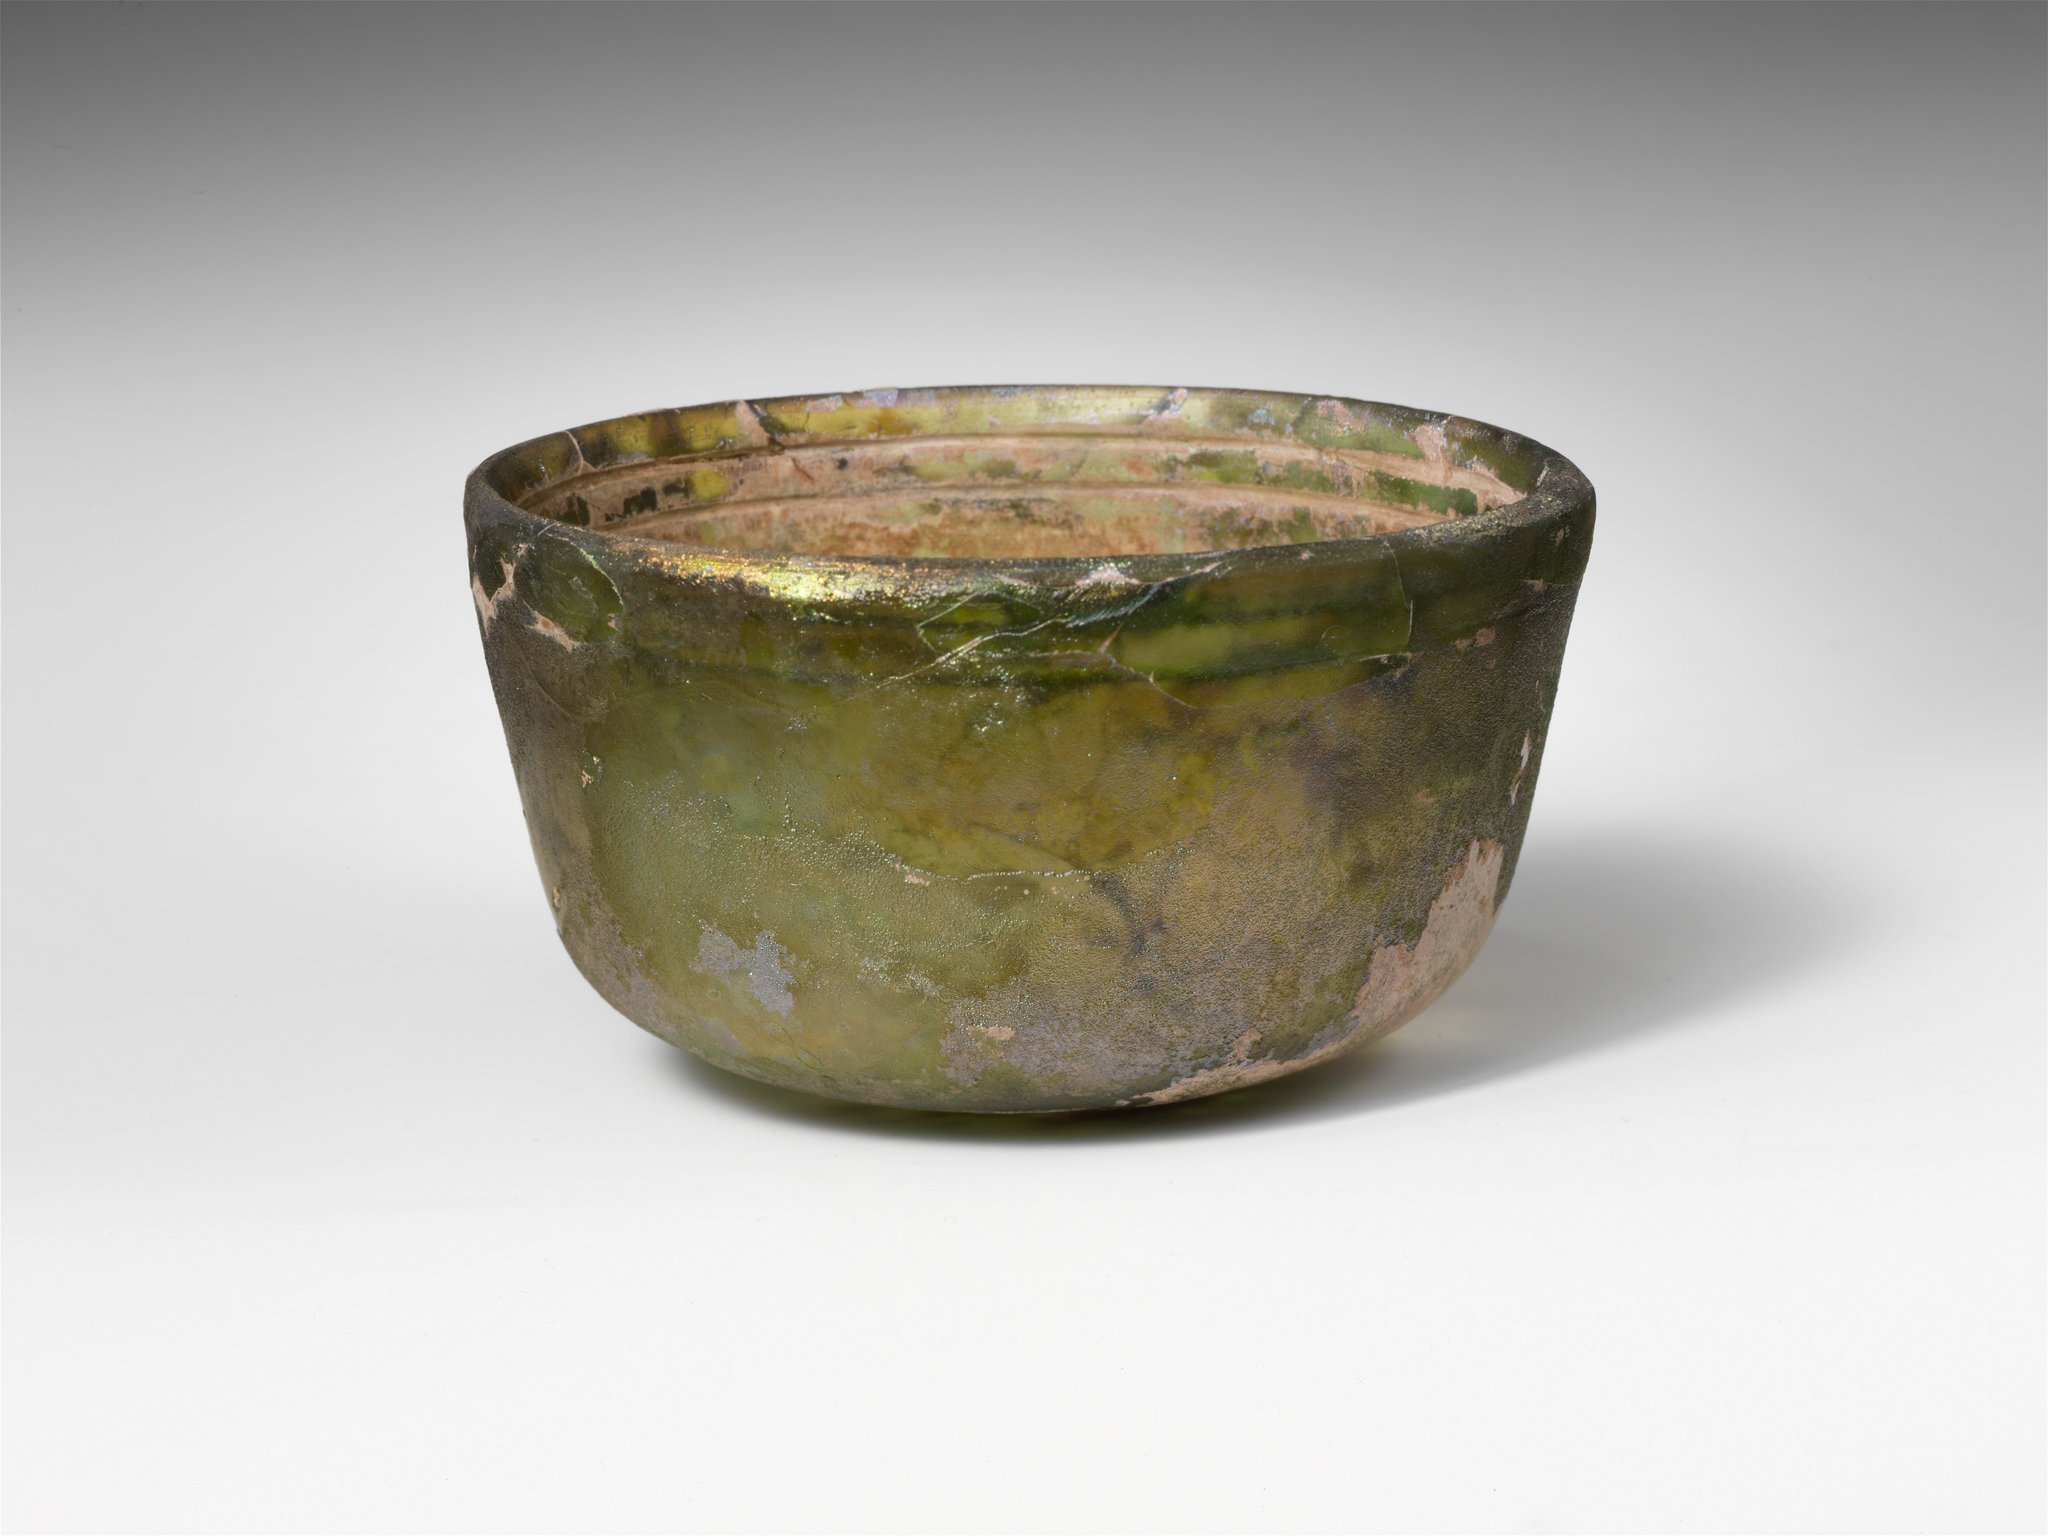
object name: bowl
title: Glass bowl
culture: roman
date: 34 BCE-33 CE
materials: glass